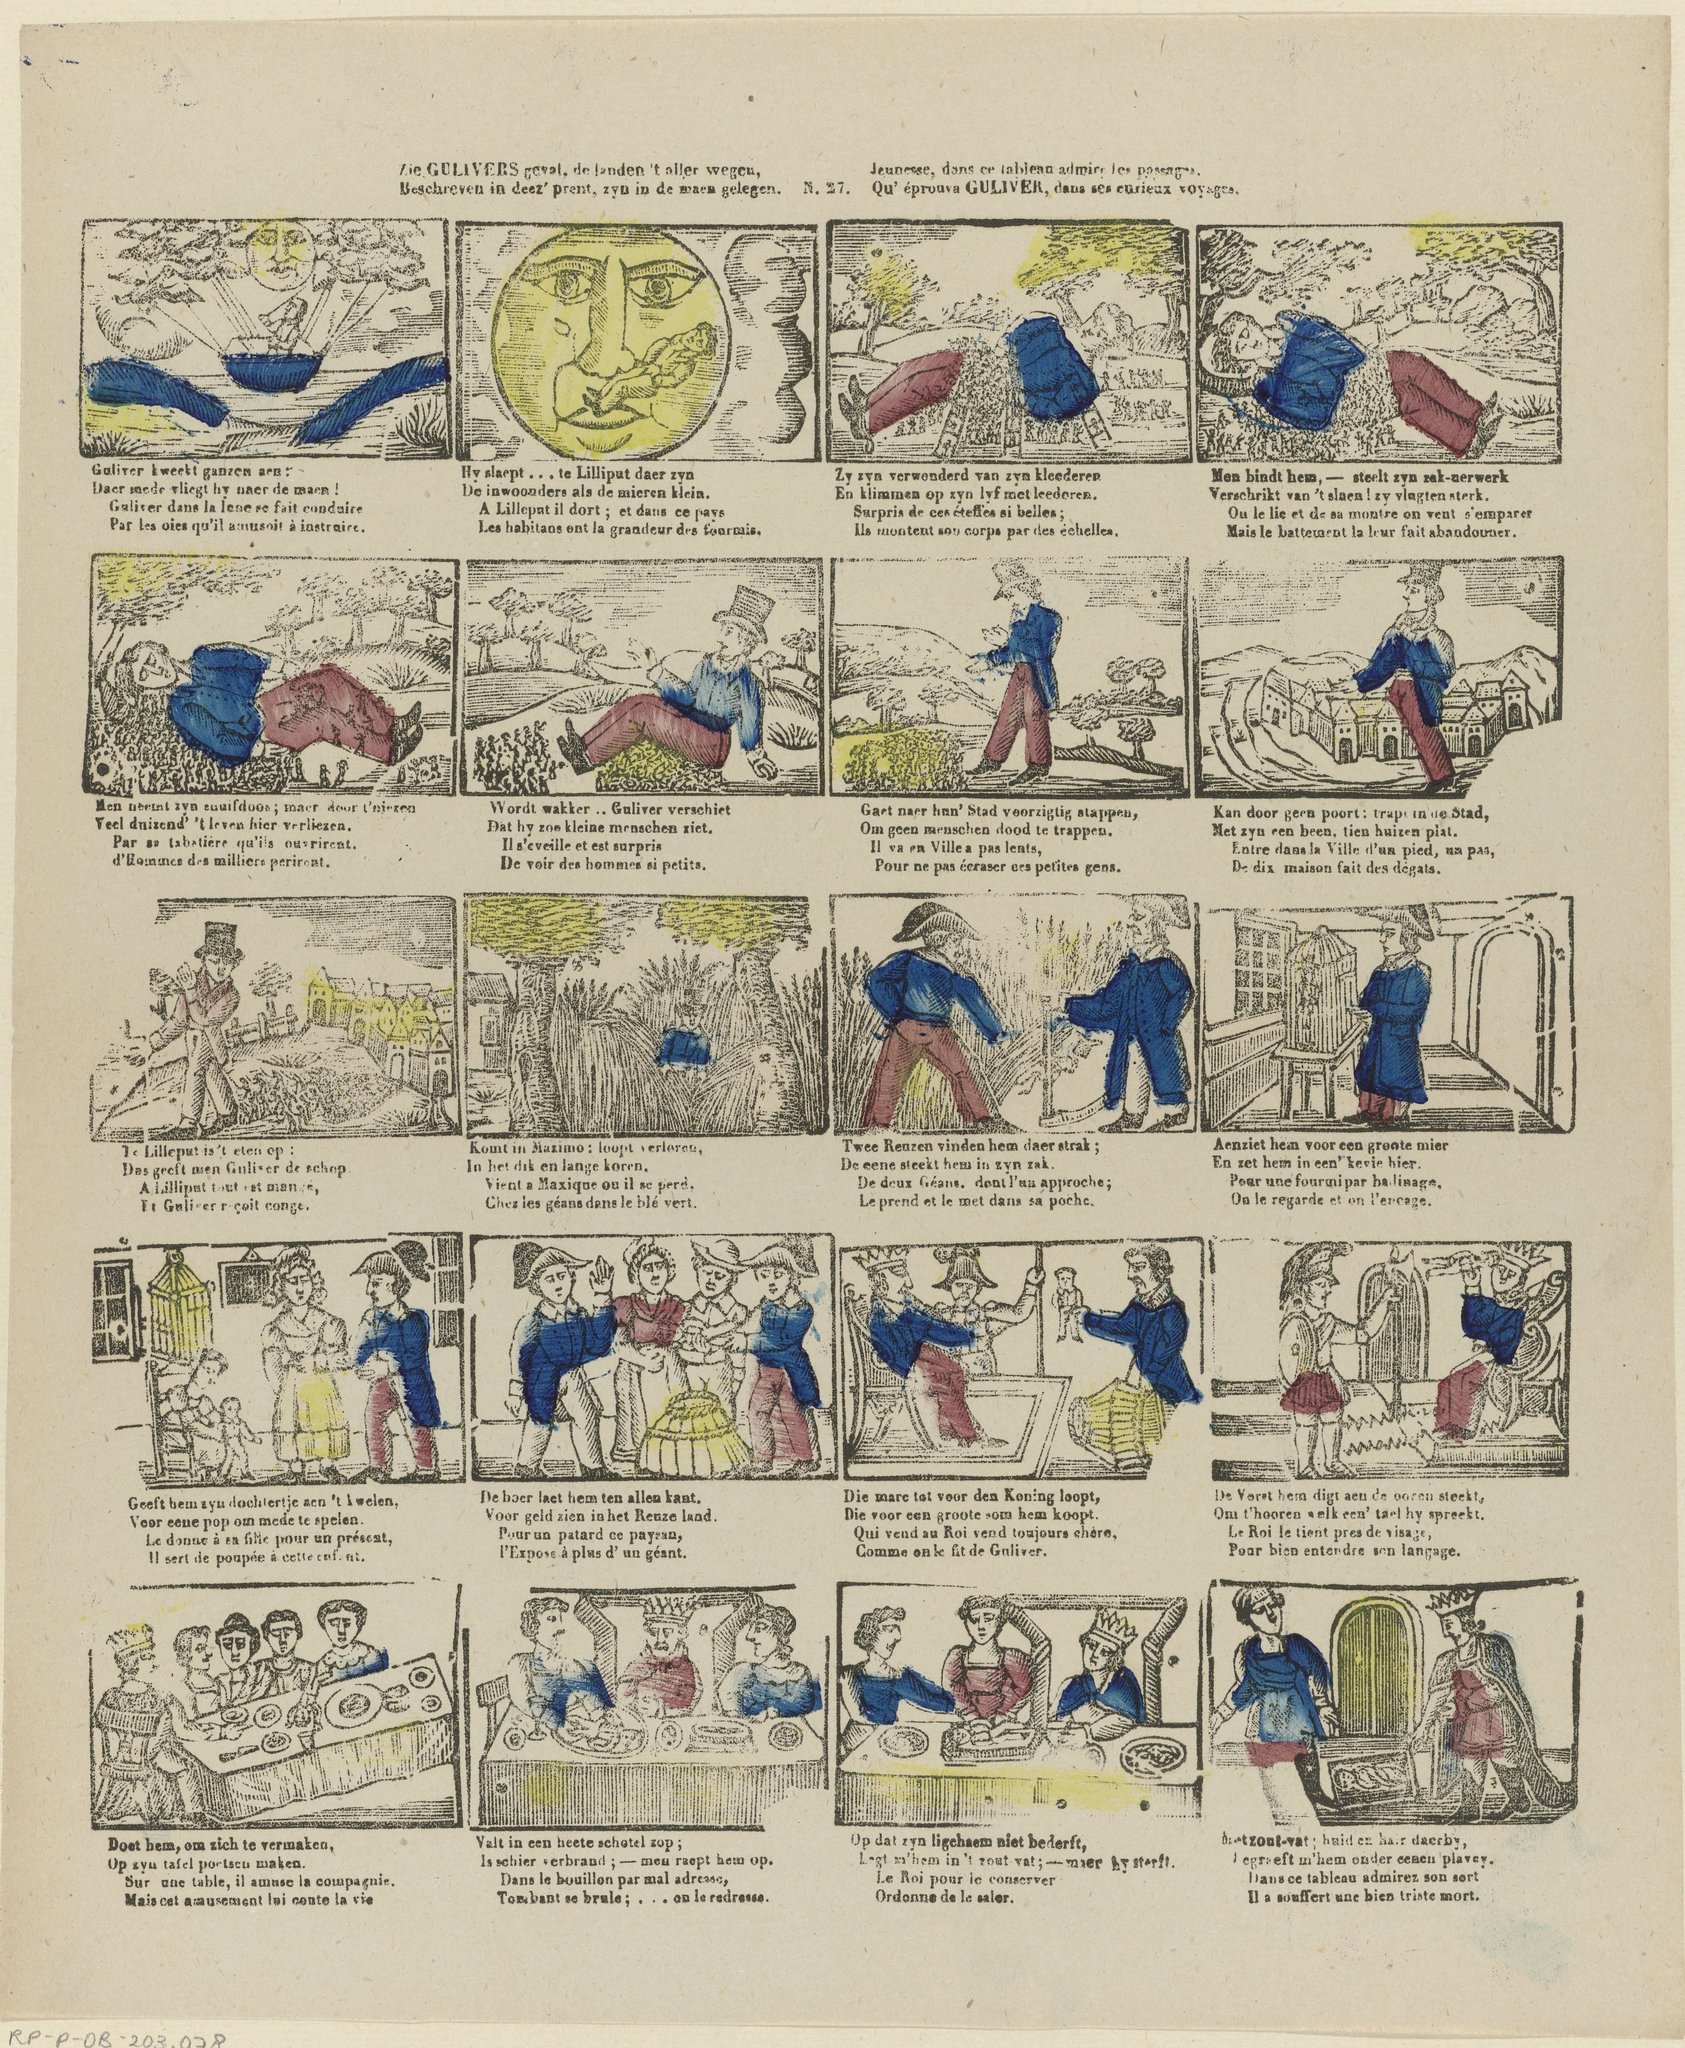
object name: popular print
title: Zie Gulivers geval, de landen 't aller wegen, / Beschreven in deez' prent, zyn in de maen gelegen. / Jeunesse, dans ce tableau admire les passages, / Qu' éprouva Guliver, dans ses curieux voyages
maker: Anonymous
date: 1856-1900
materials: paper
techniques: colour, letterpress printing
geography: turnhout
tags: (scenes from) specific works of literature: swift, gulliver's travels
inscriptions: collector's mark: Lugt 2760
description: Blad met 20 voorstellingen uit Gullivers reizen, waaronder Gulliver in Lilliput en twee reuzen die Gulliver gevangennemen. Onder elke voorstelling een tweeregelig vers in het Nederlands en het Frans. Genummerd midden boven: N. 27.